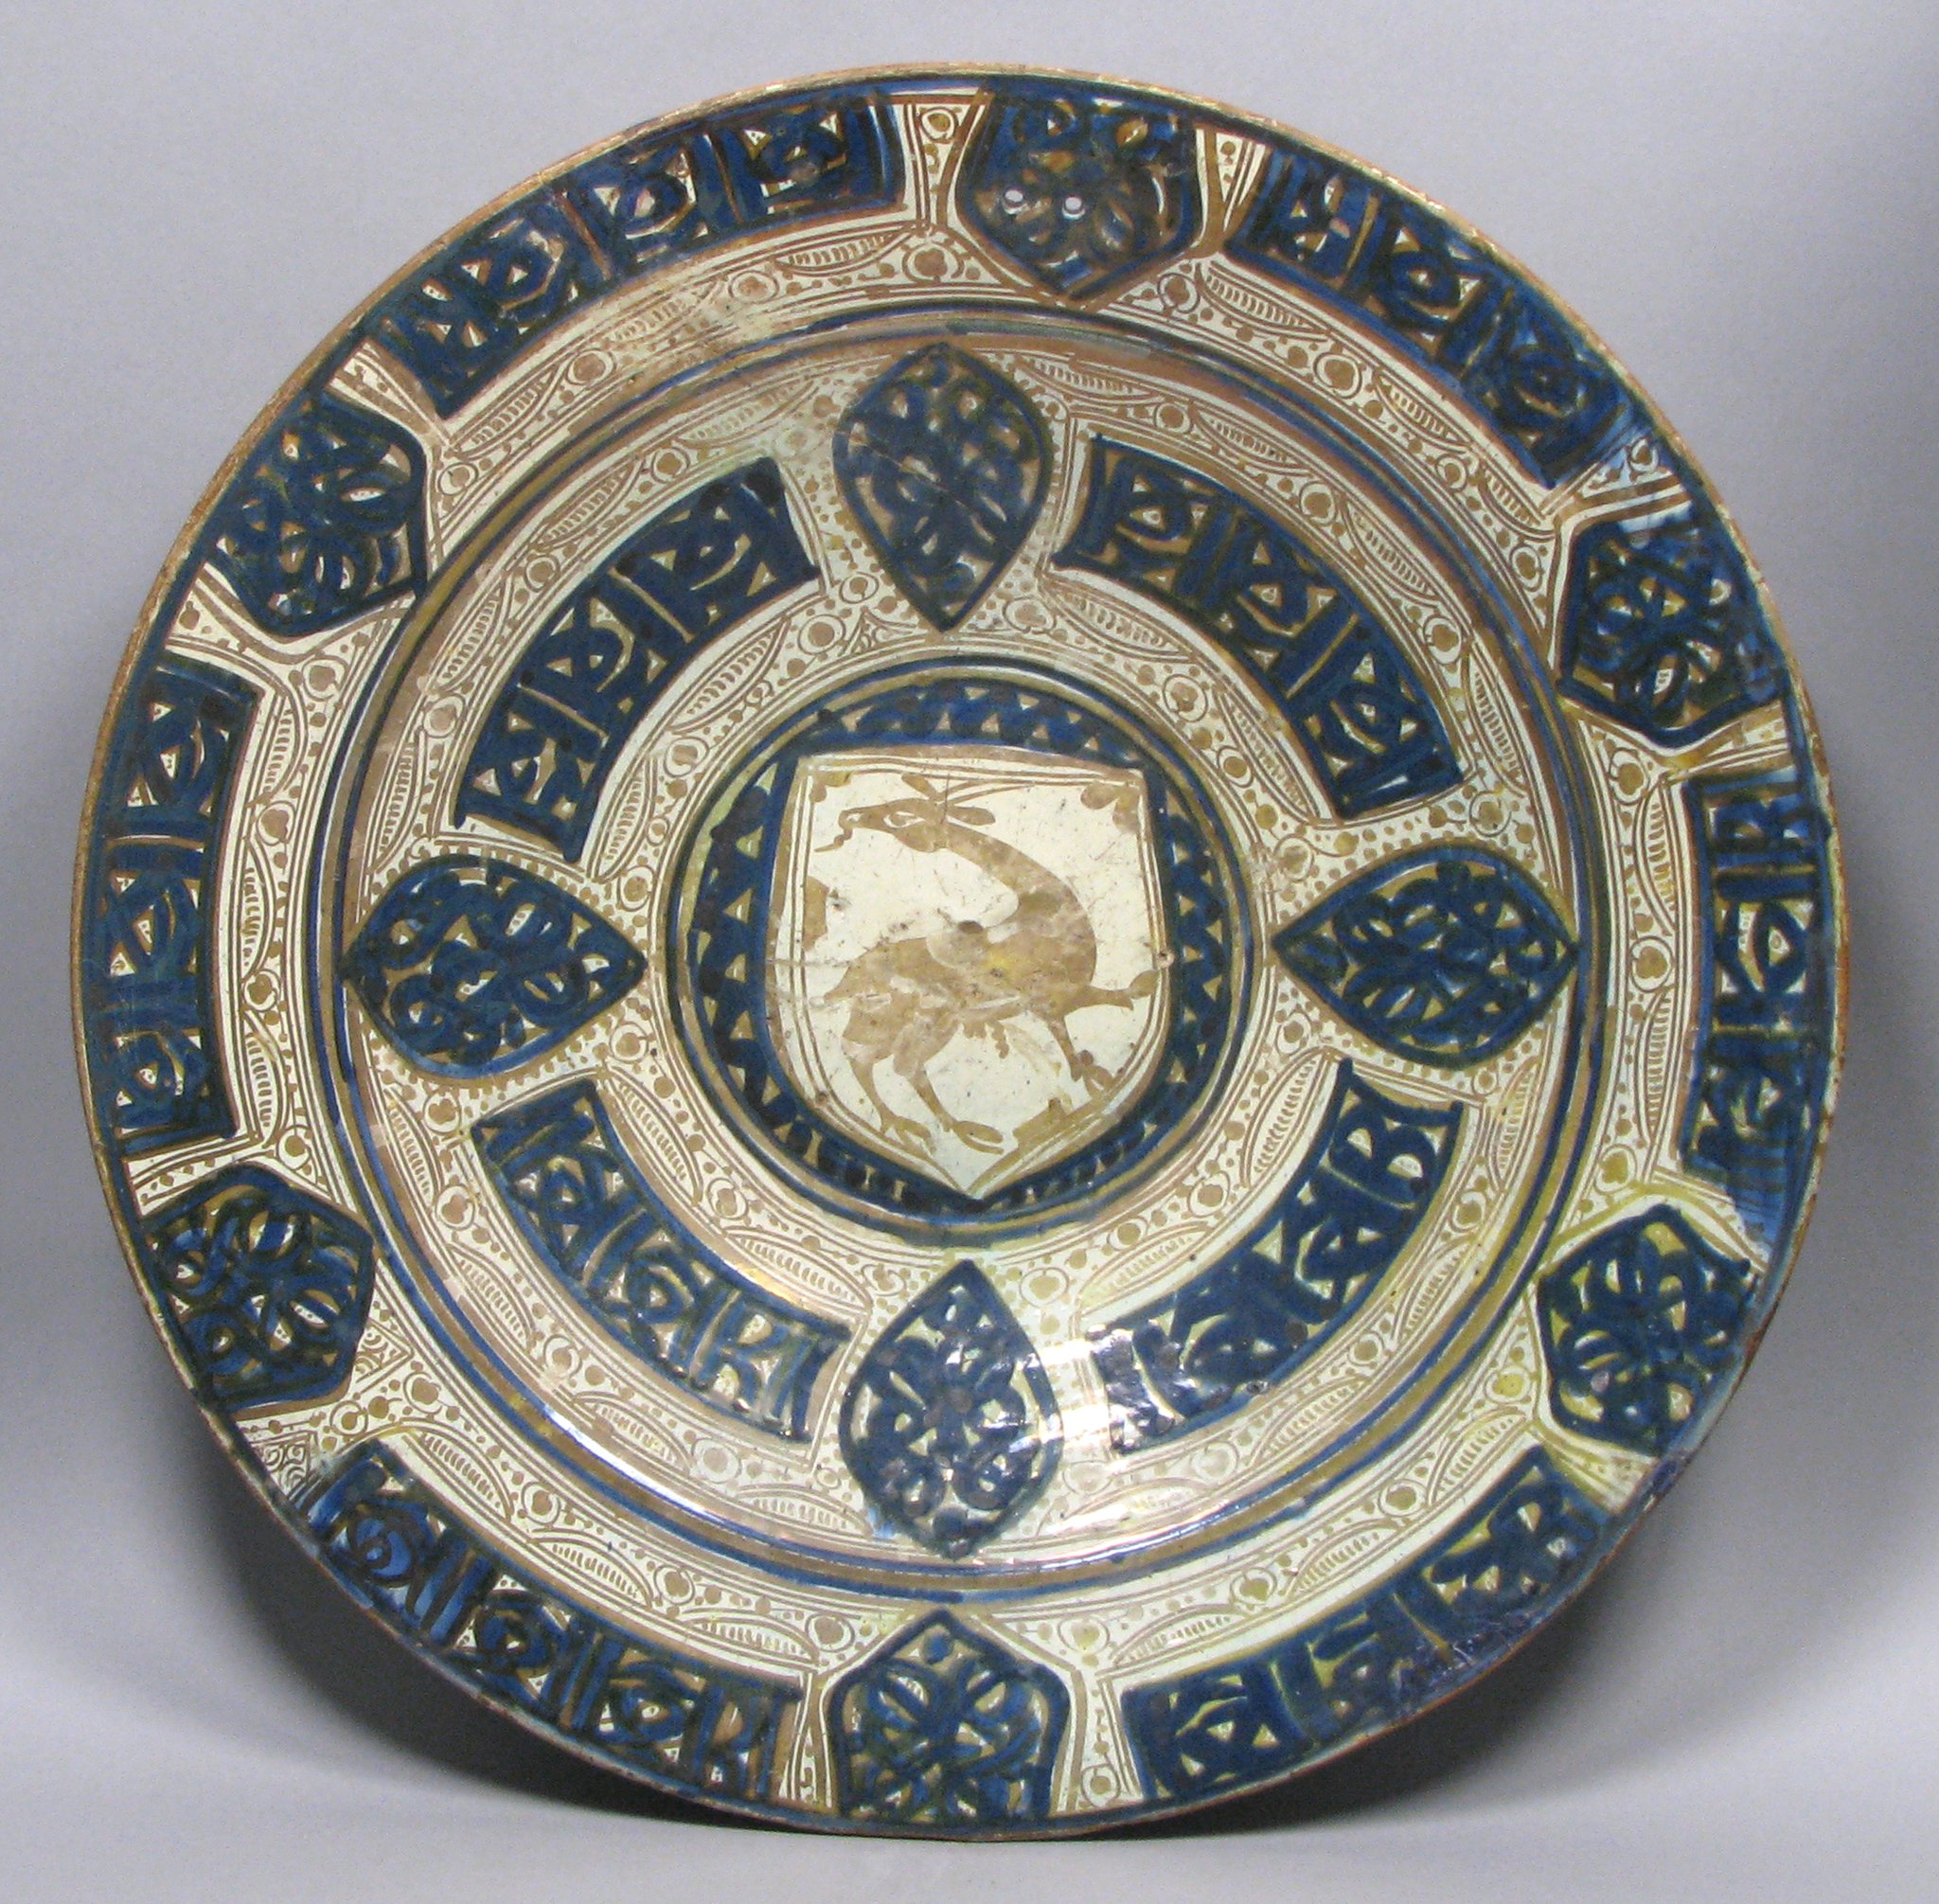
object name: plate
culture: spanish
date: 1420-1430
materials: earthenware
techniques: glazing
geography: spain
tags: animals